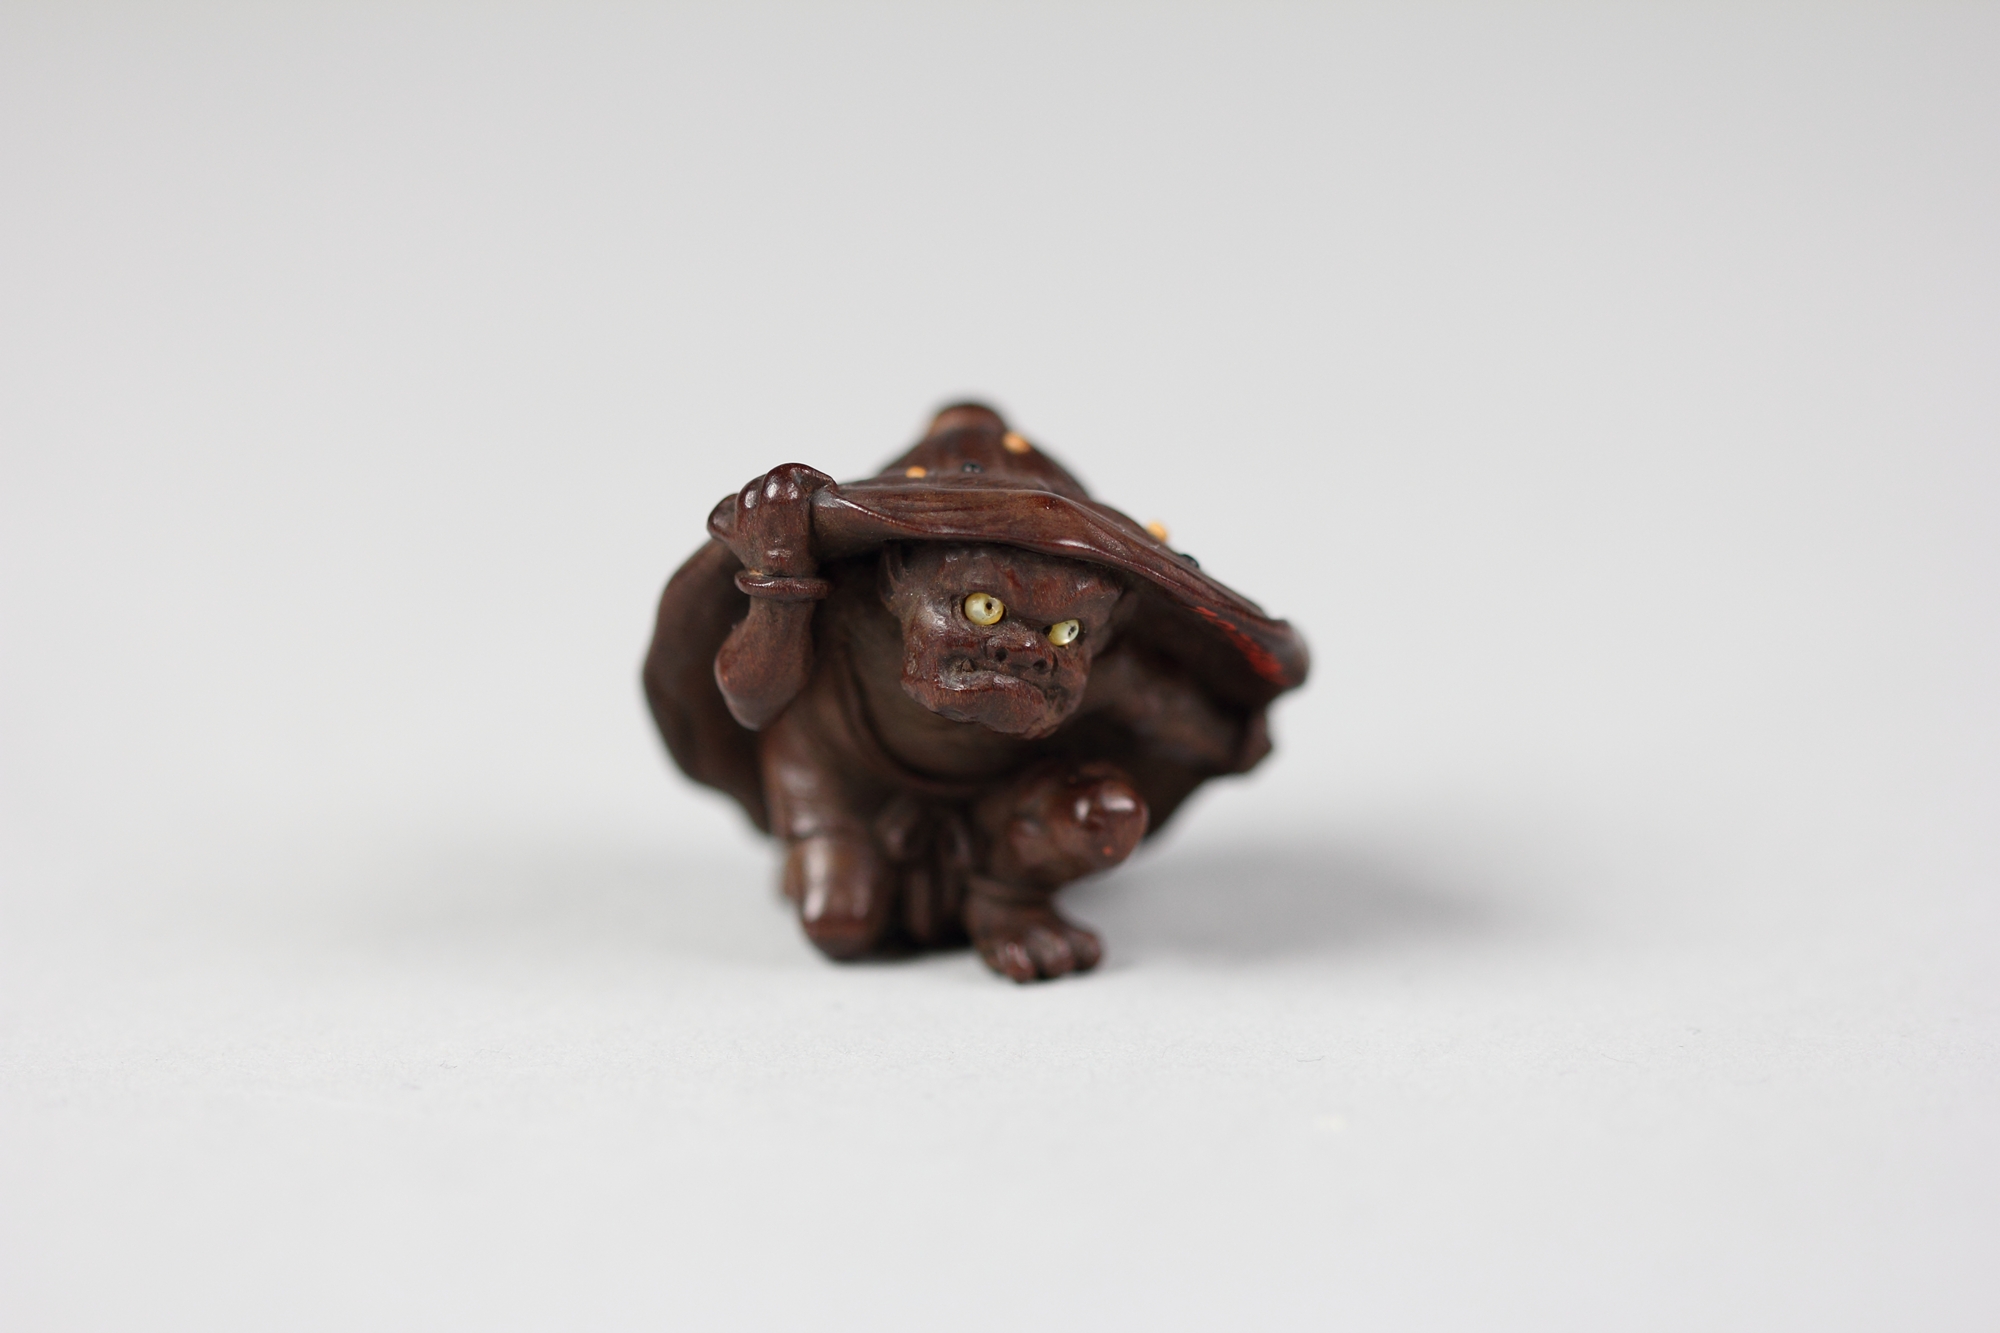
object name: netsuke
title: Netsuke of Demon under a Lotus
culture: japanese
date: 1801-1900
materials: wood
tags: demons